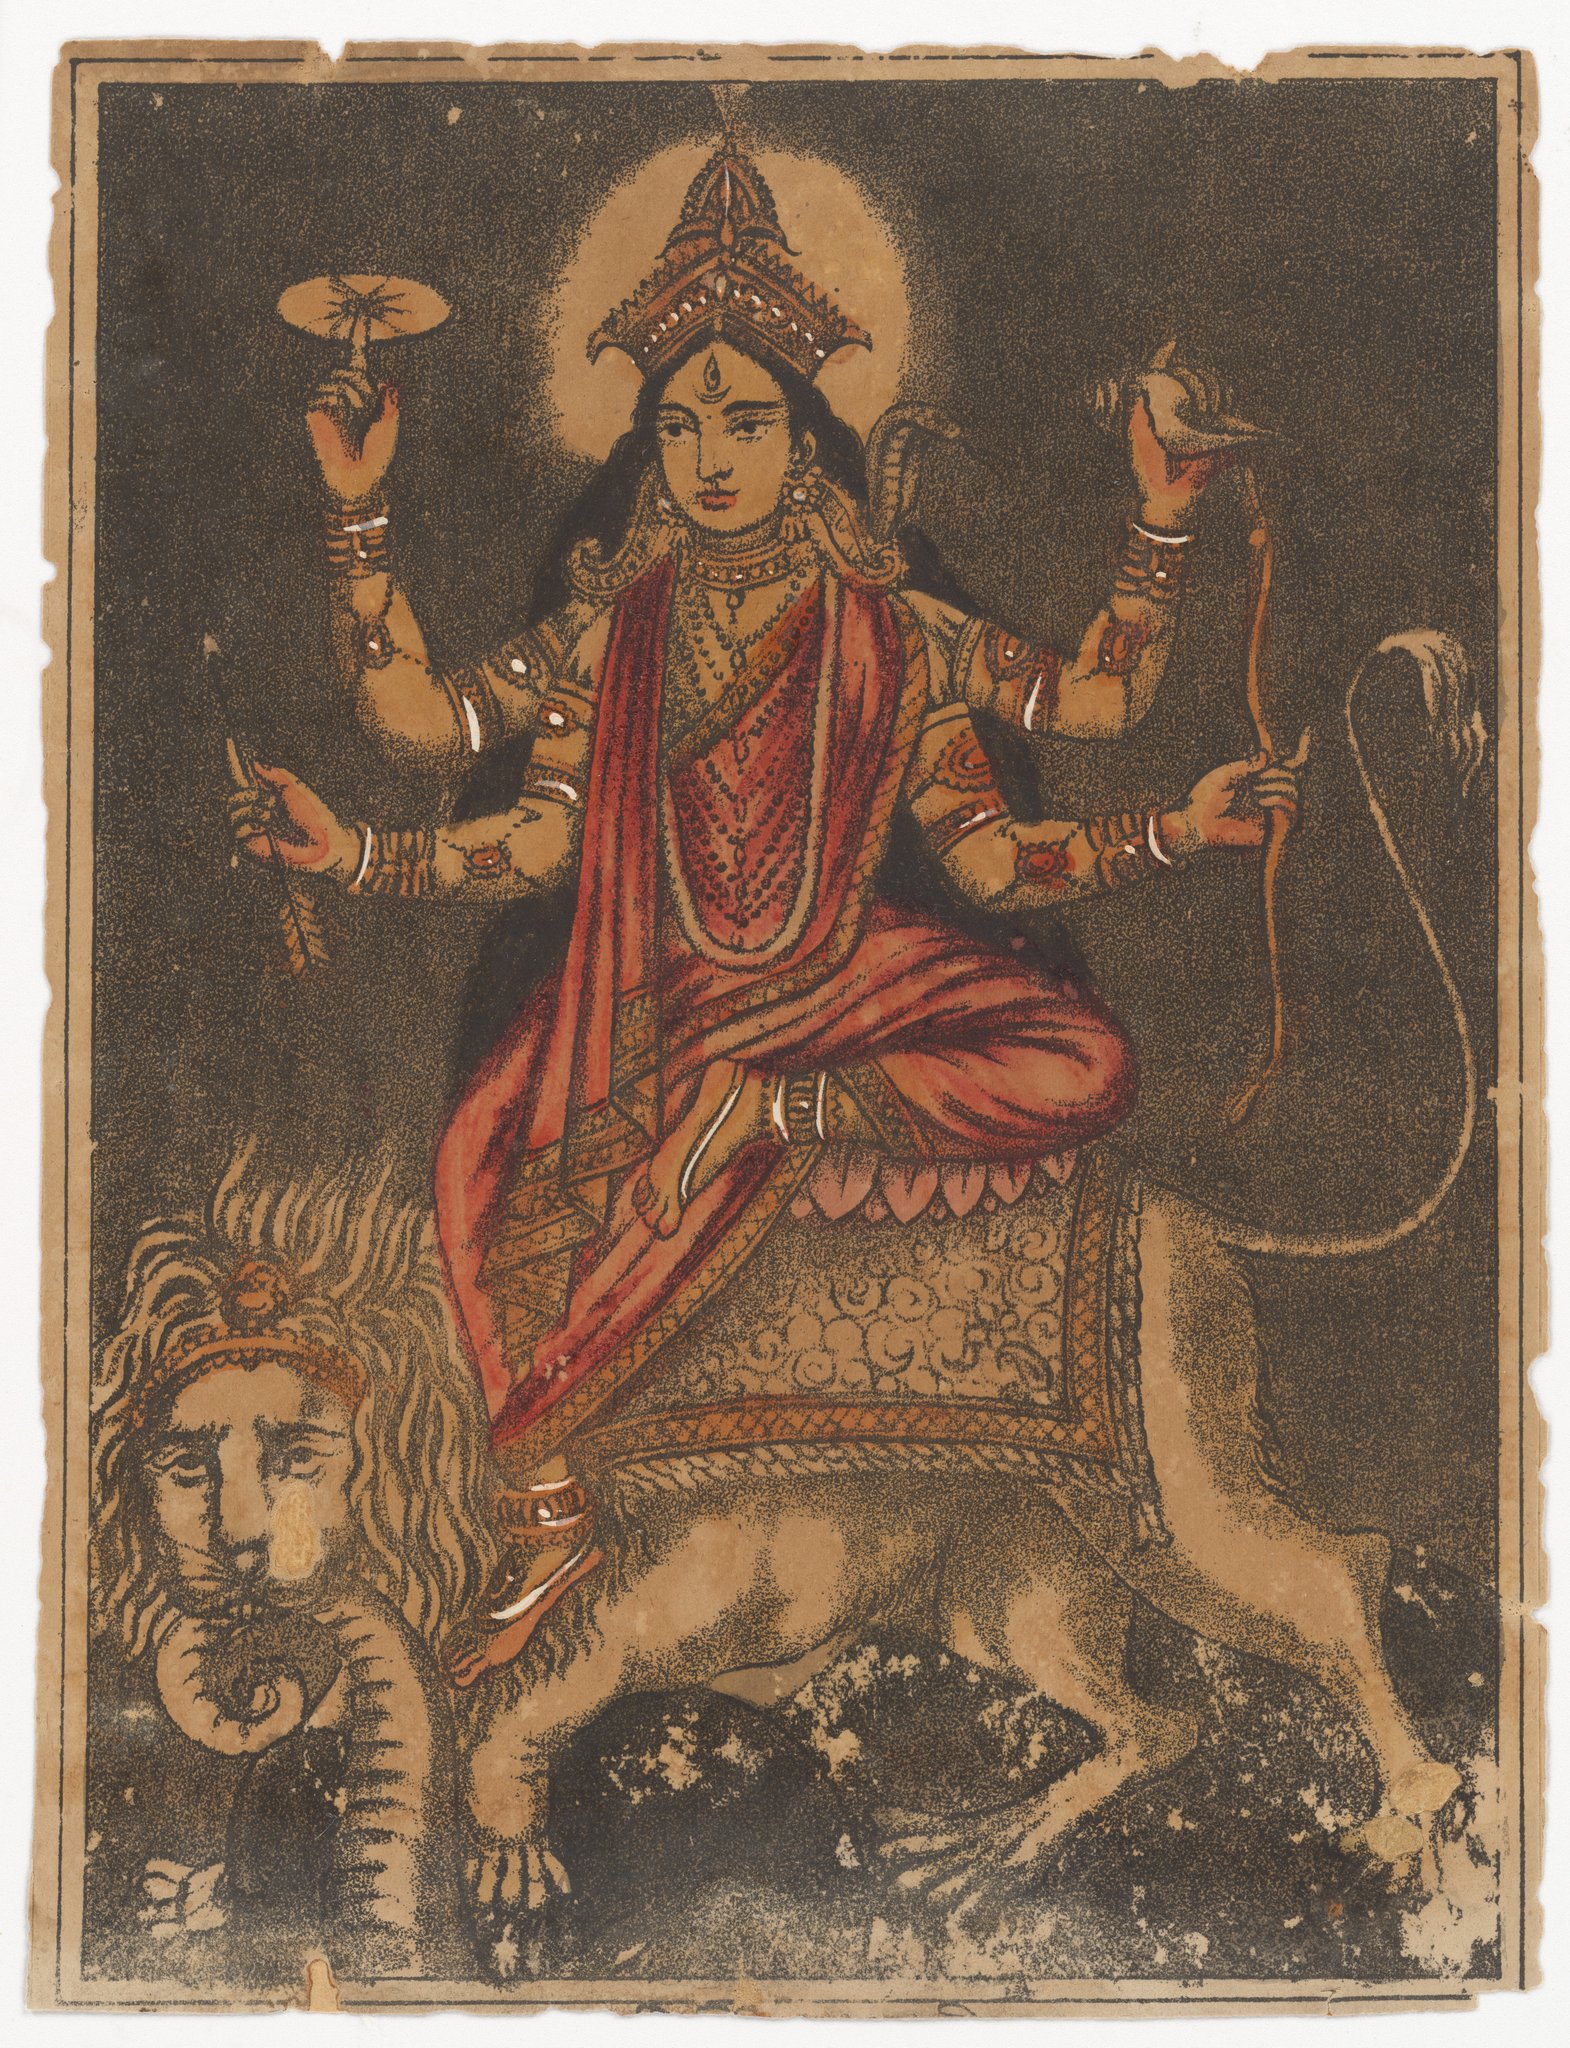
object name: lithograph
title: Goddess Jagadhatri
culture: west bengali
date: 1870-1880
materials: gouache, watercolor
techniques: hand coloring, lithograph, printing